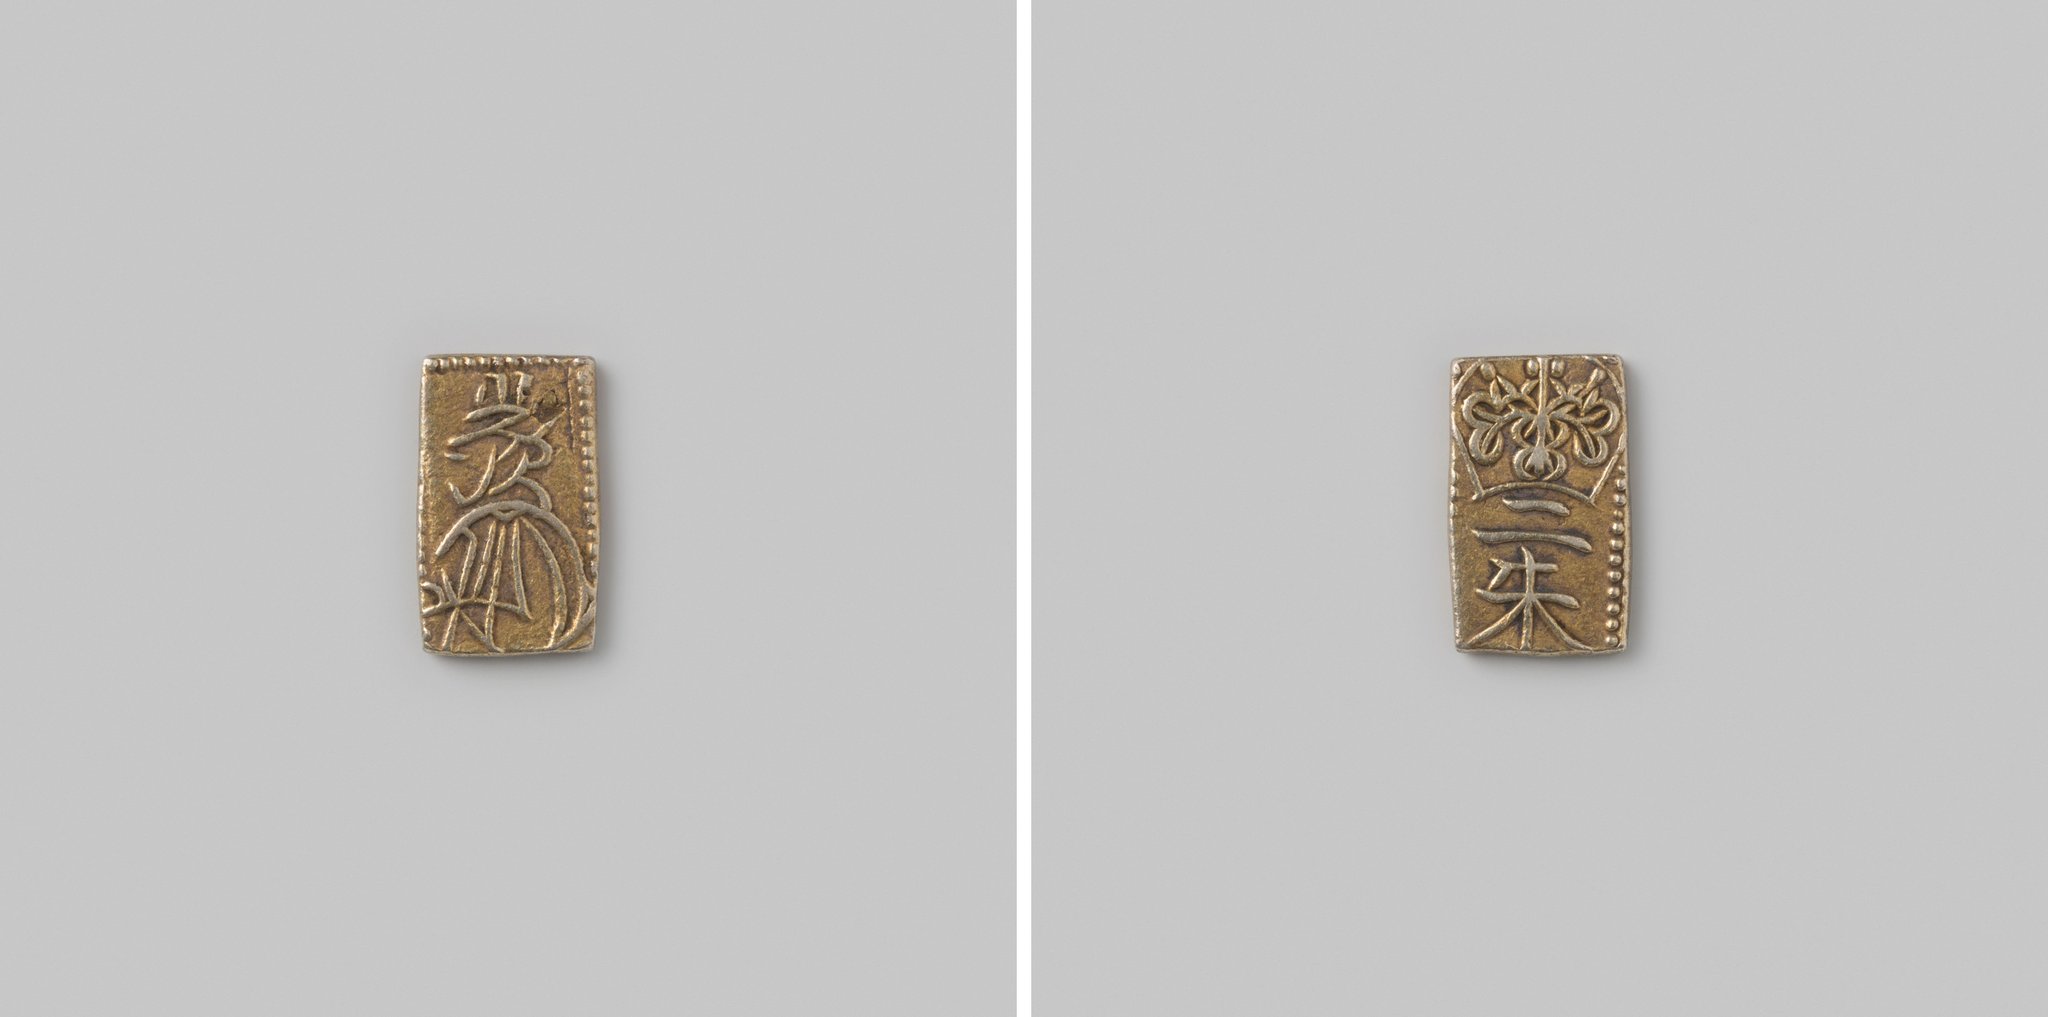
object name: coin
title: Ichi bu kin = gouden ichi bu van het keizerrijk Japan van keizer Nin kau uit het Tenpo tijdperk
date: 1830-1843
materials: gold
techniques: striking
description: Gouden rechthoekige munt. Voorzijde: twee naar elkaar toegewende bloem-motieven, waartussen waarde-aanduiding: ichi = een, aangegeven door een liggende streep rechts en links het letterteken voor bu. Keerzijde: binnen rechthoek onder elkaar geplaatste tekens met rechtsboven het teken voor het tenpo tijdperk.